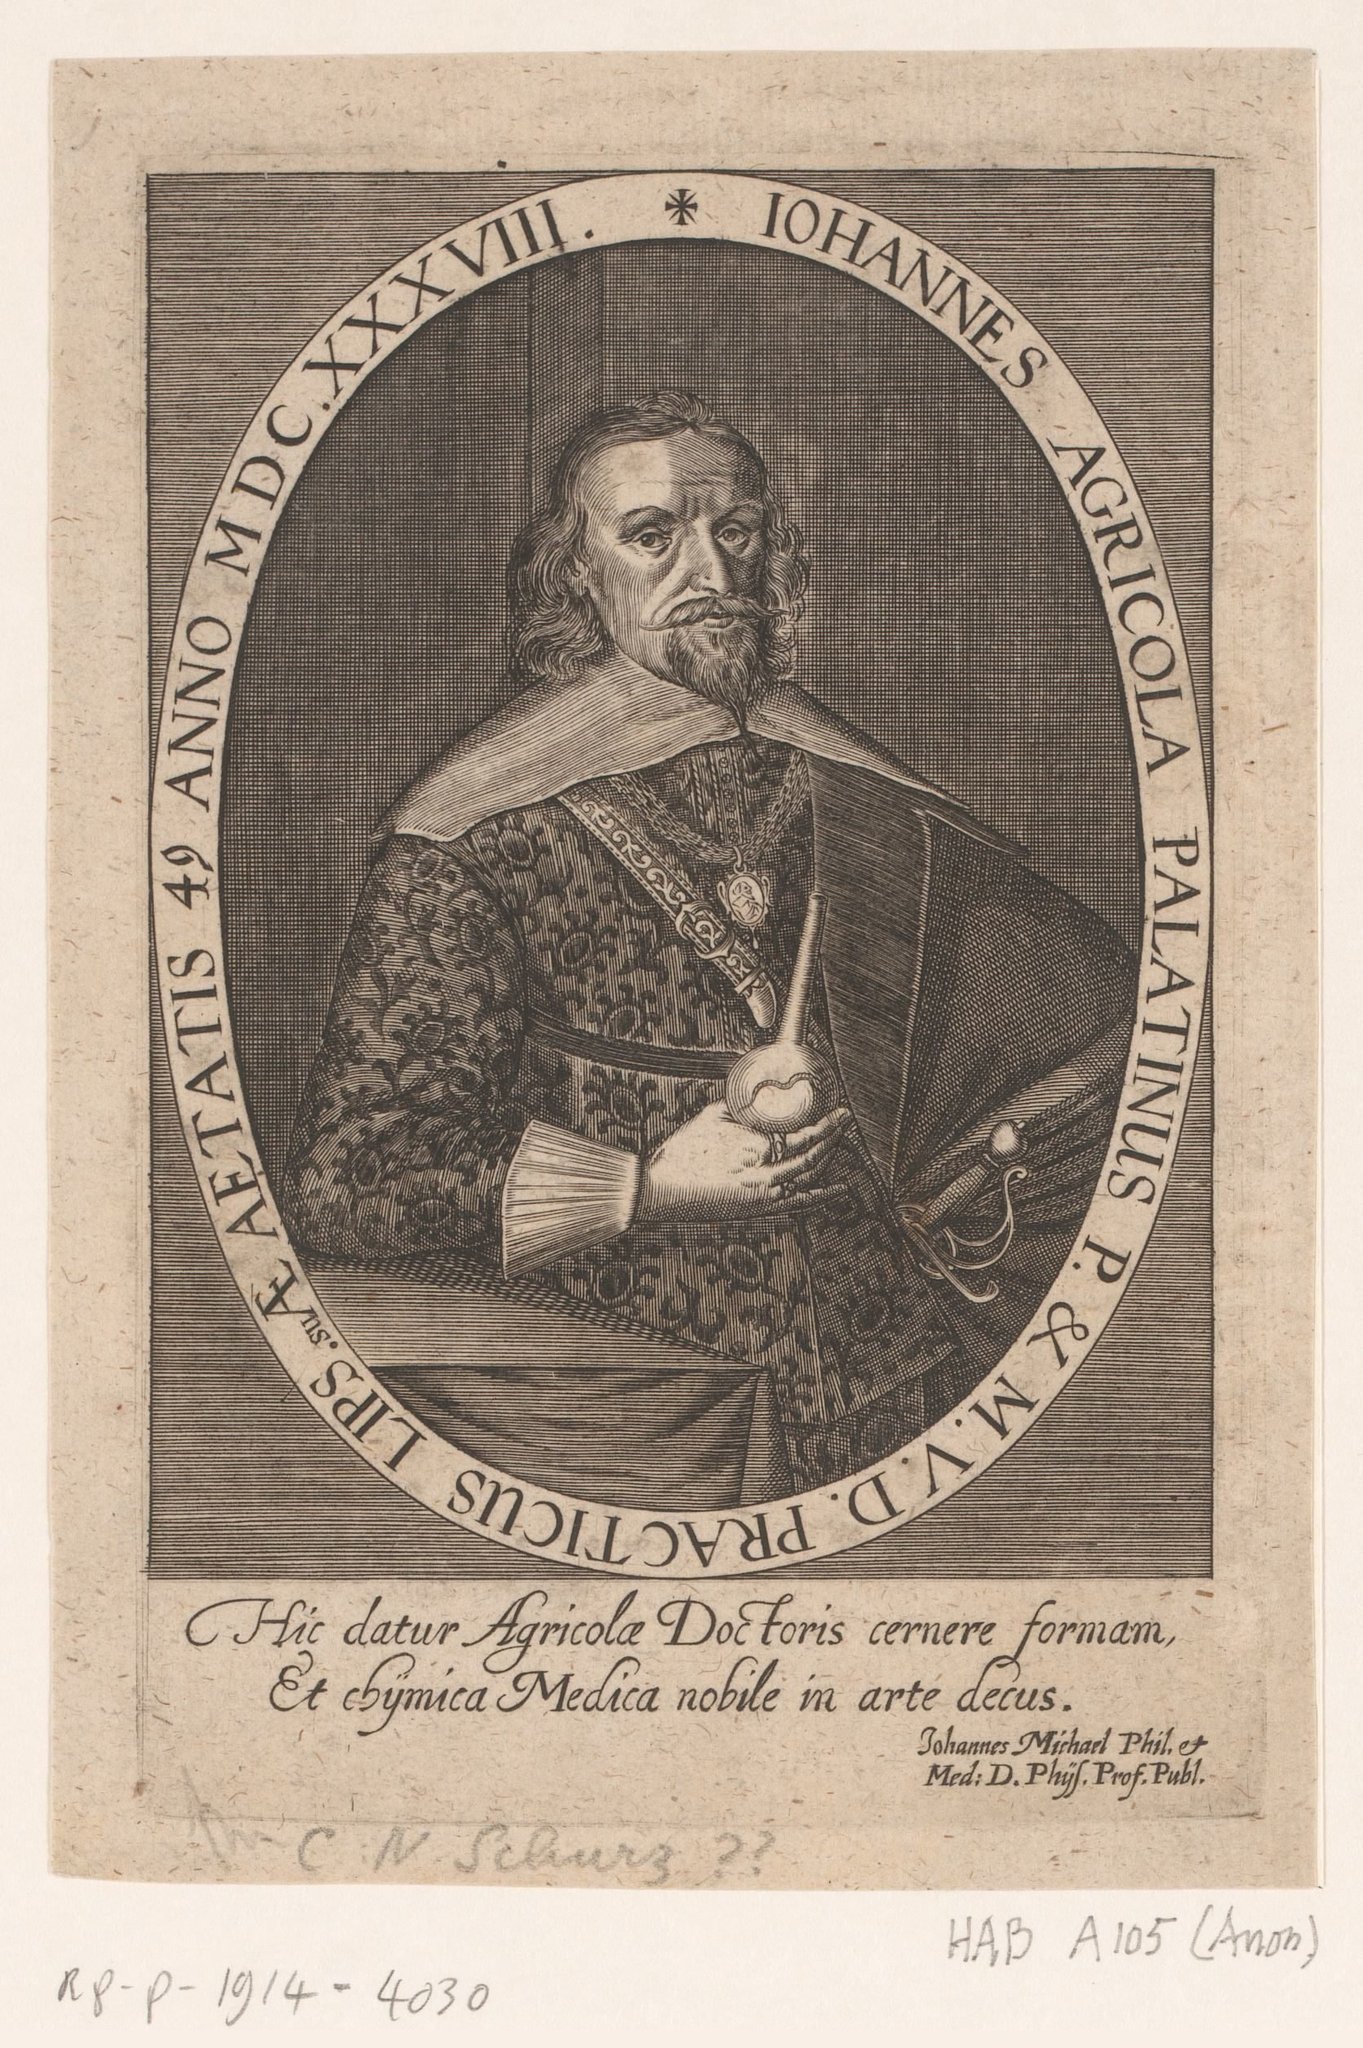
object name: print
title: Portret van Johannes Agricola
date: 1600-1699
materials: paper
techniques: engraving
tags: historical persons, alchemy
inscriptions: collector's mark: Lugt 2228